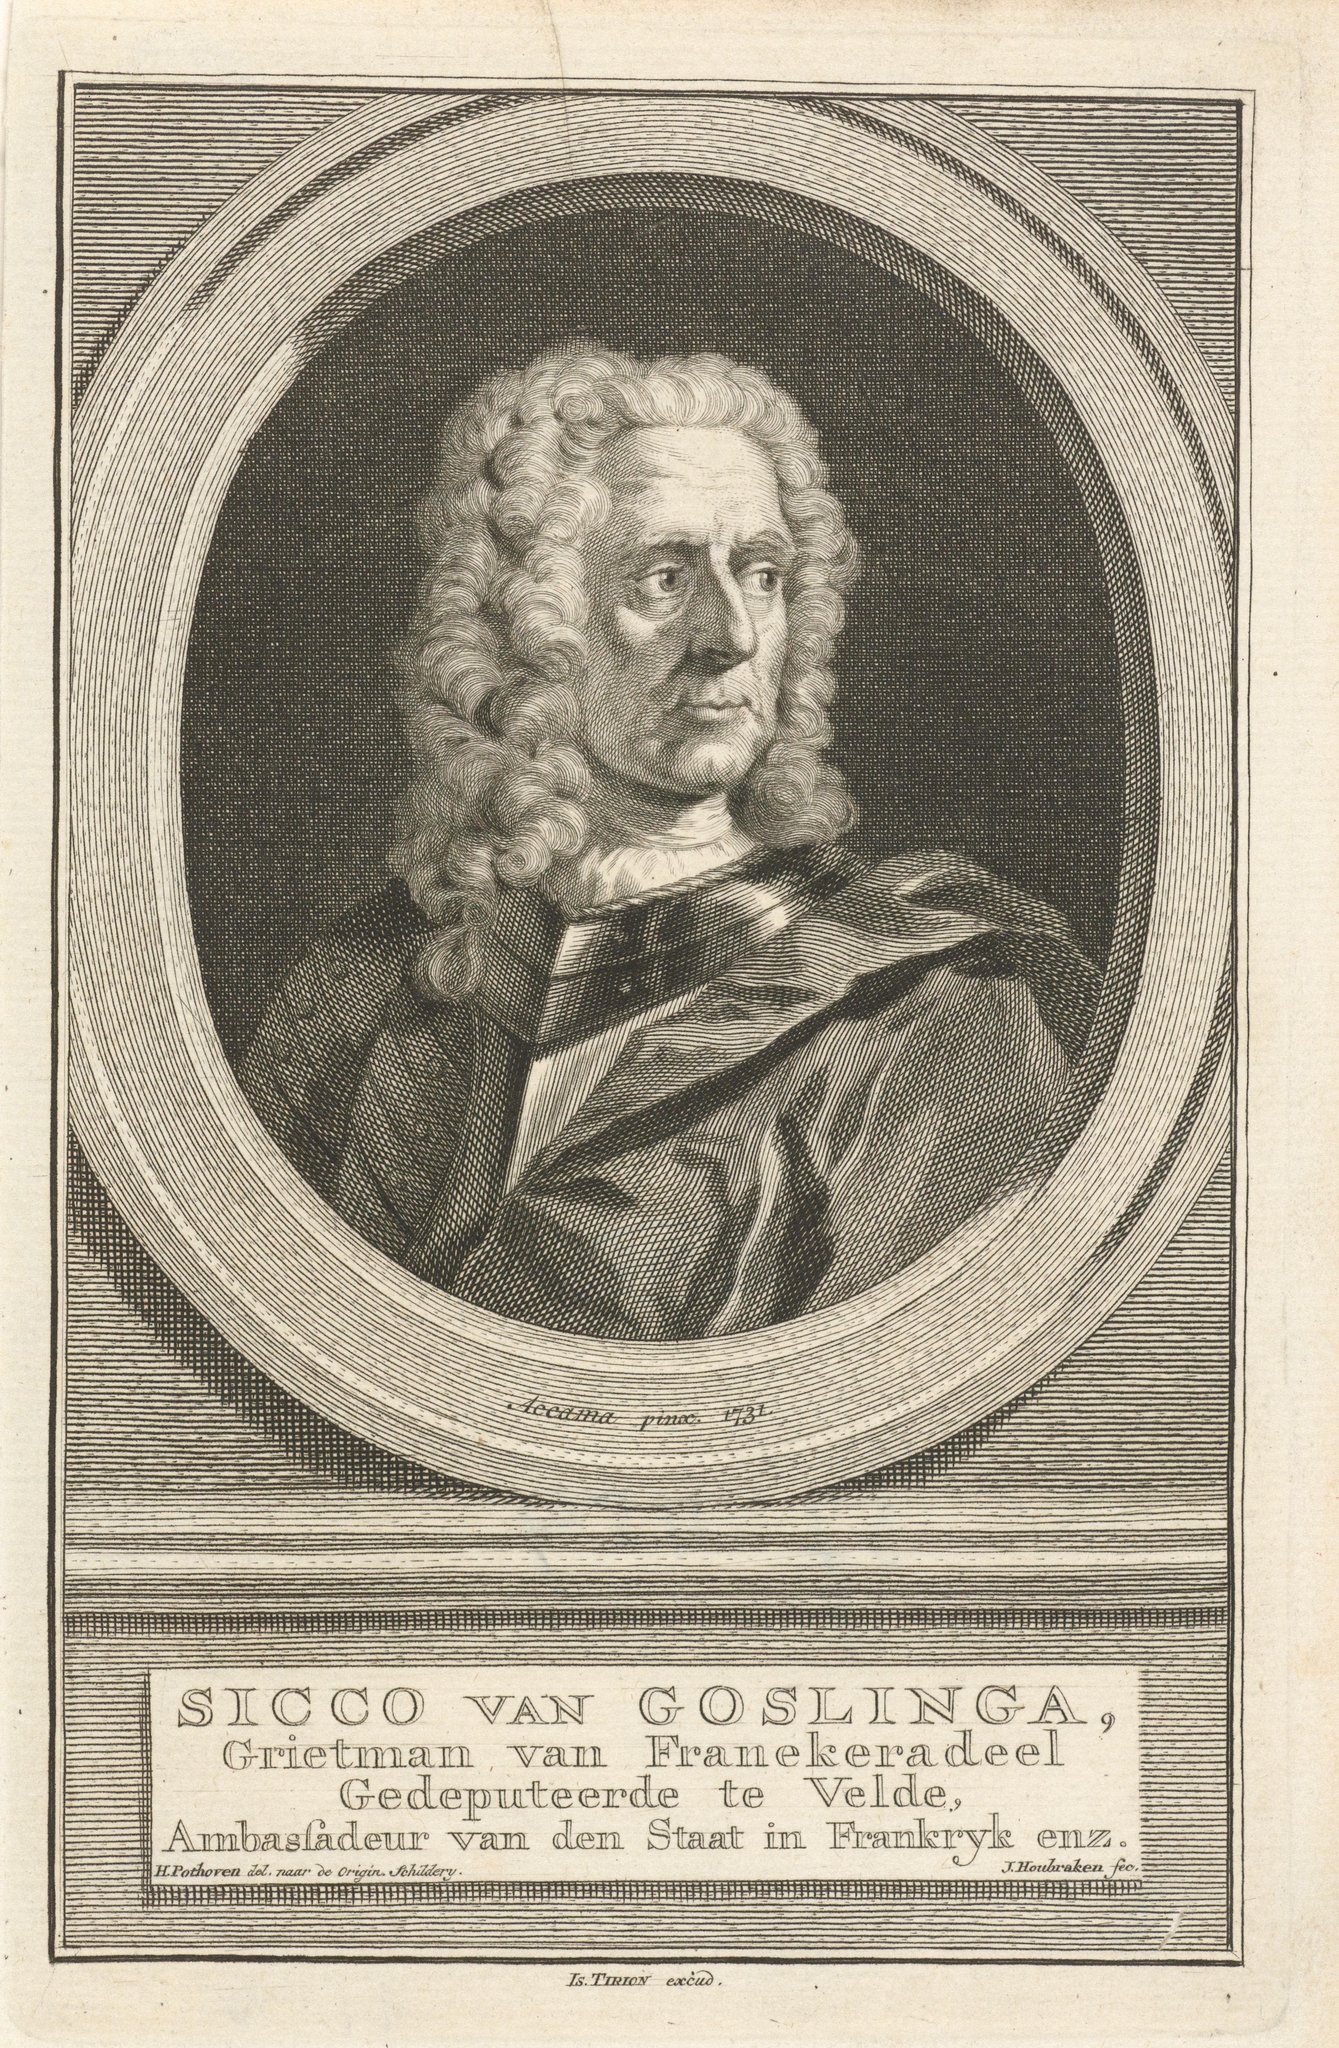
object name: print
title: Sicco van Goslinga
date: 1749-1759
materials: paper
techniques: engraving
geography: amsterdam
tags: sicco van goslinga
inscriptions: collector's mark: Lugt 2228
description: Prent ook gebruikt in: Jan Wagenaar, Vaderlandsche historie, vervattende de geschiedenissen der nu Vereenigde Nederlanden, inzonderheid die van Holland (...), 21 delen. Amsterdam, Isaak Tirion, 1749-59.